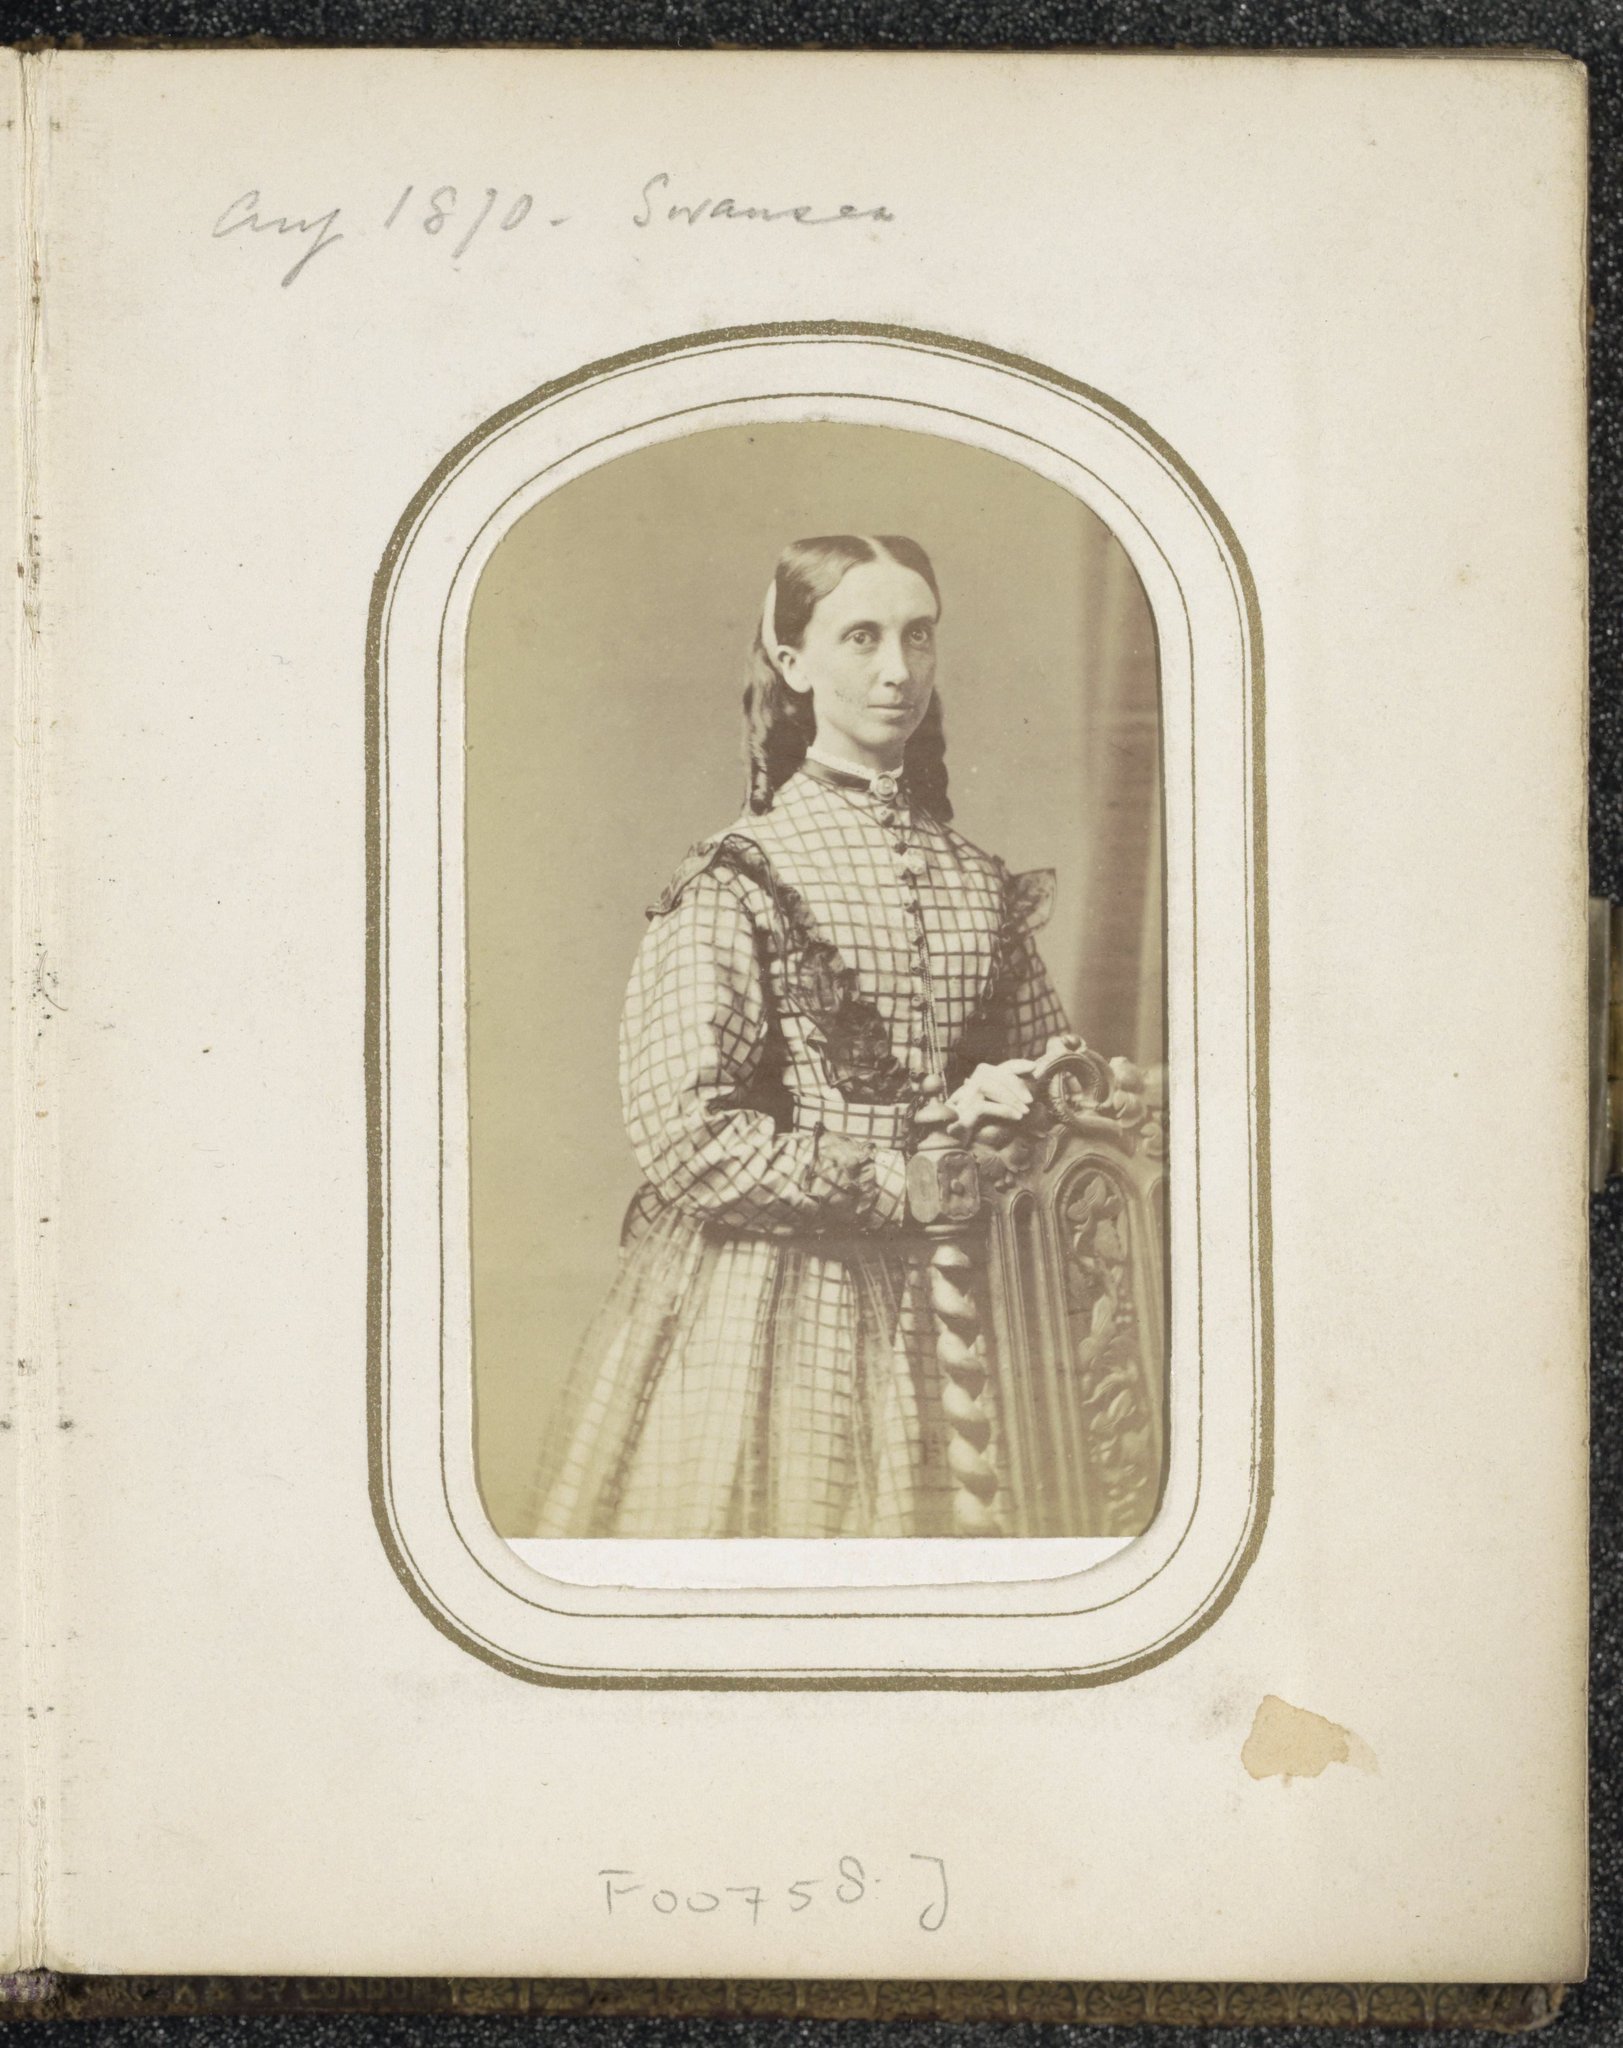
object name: carte de visite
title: Portret van een vrouw bij een stoel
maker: james andrews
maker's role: fotograaf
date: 1808-1870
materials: cardboard, paper, photographic support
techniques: albumen print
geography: swansea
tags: studio requisites ~ photographer, historical persons, dress, gown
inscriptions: inscription: ‘Aug 1870. Swansea’, address: ‘Swansea, Wind Street; Carmarthen, The Parade’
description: Onderdeel van Engels fotoalbum van E.A. Kettle met 42 cartes-de-visite.